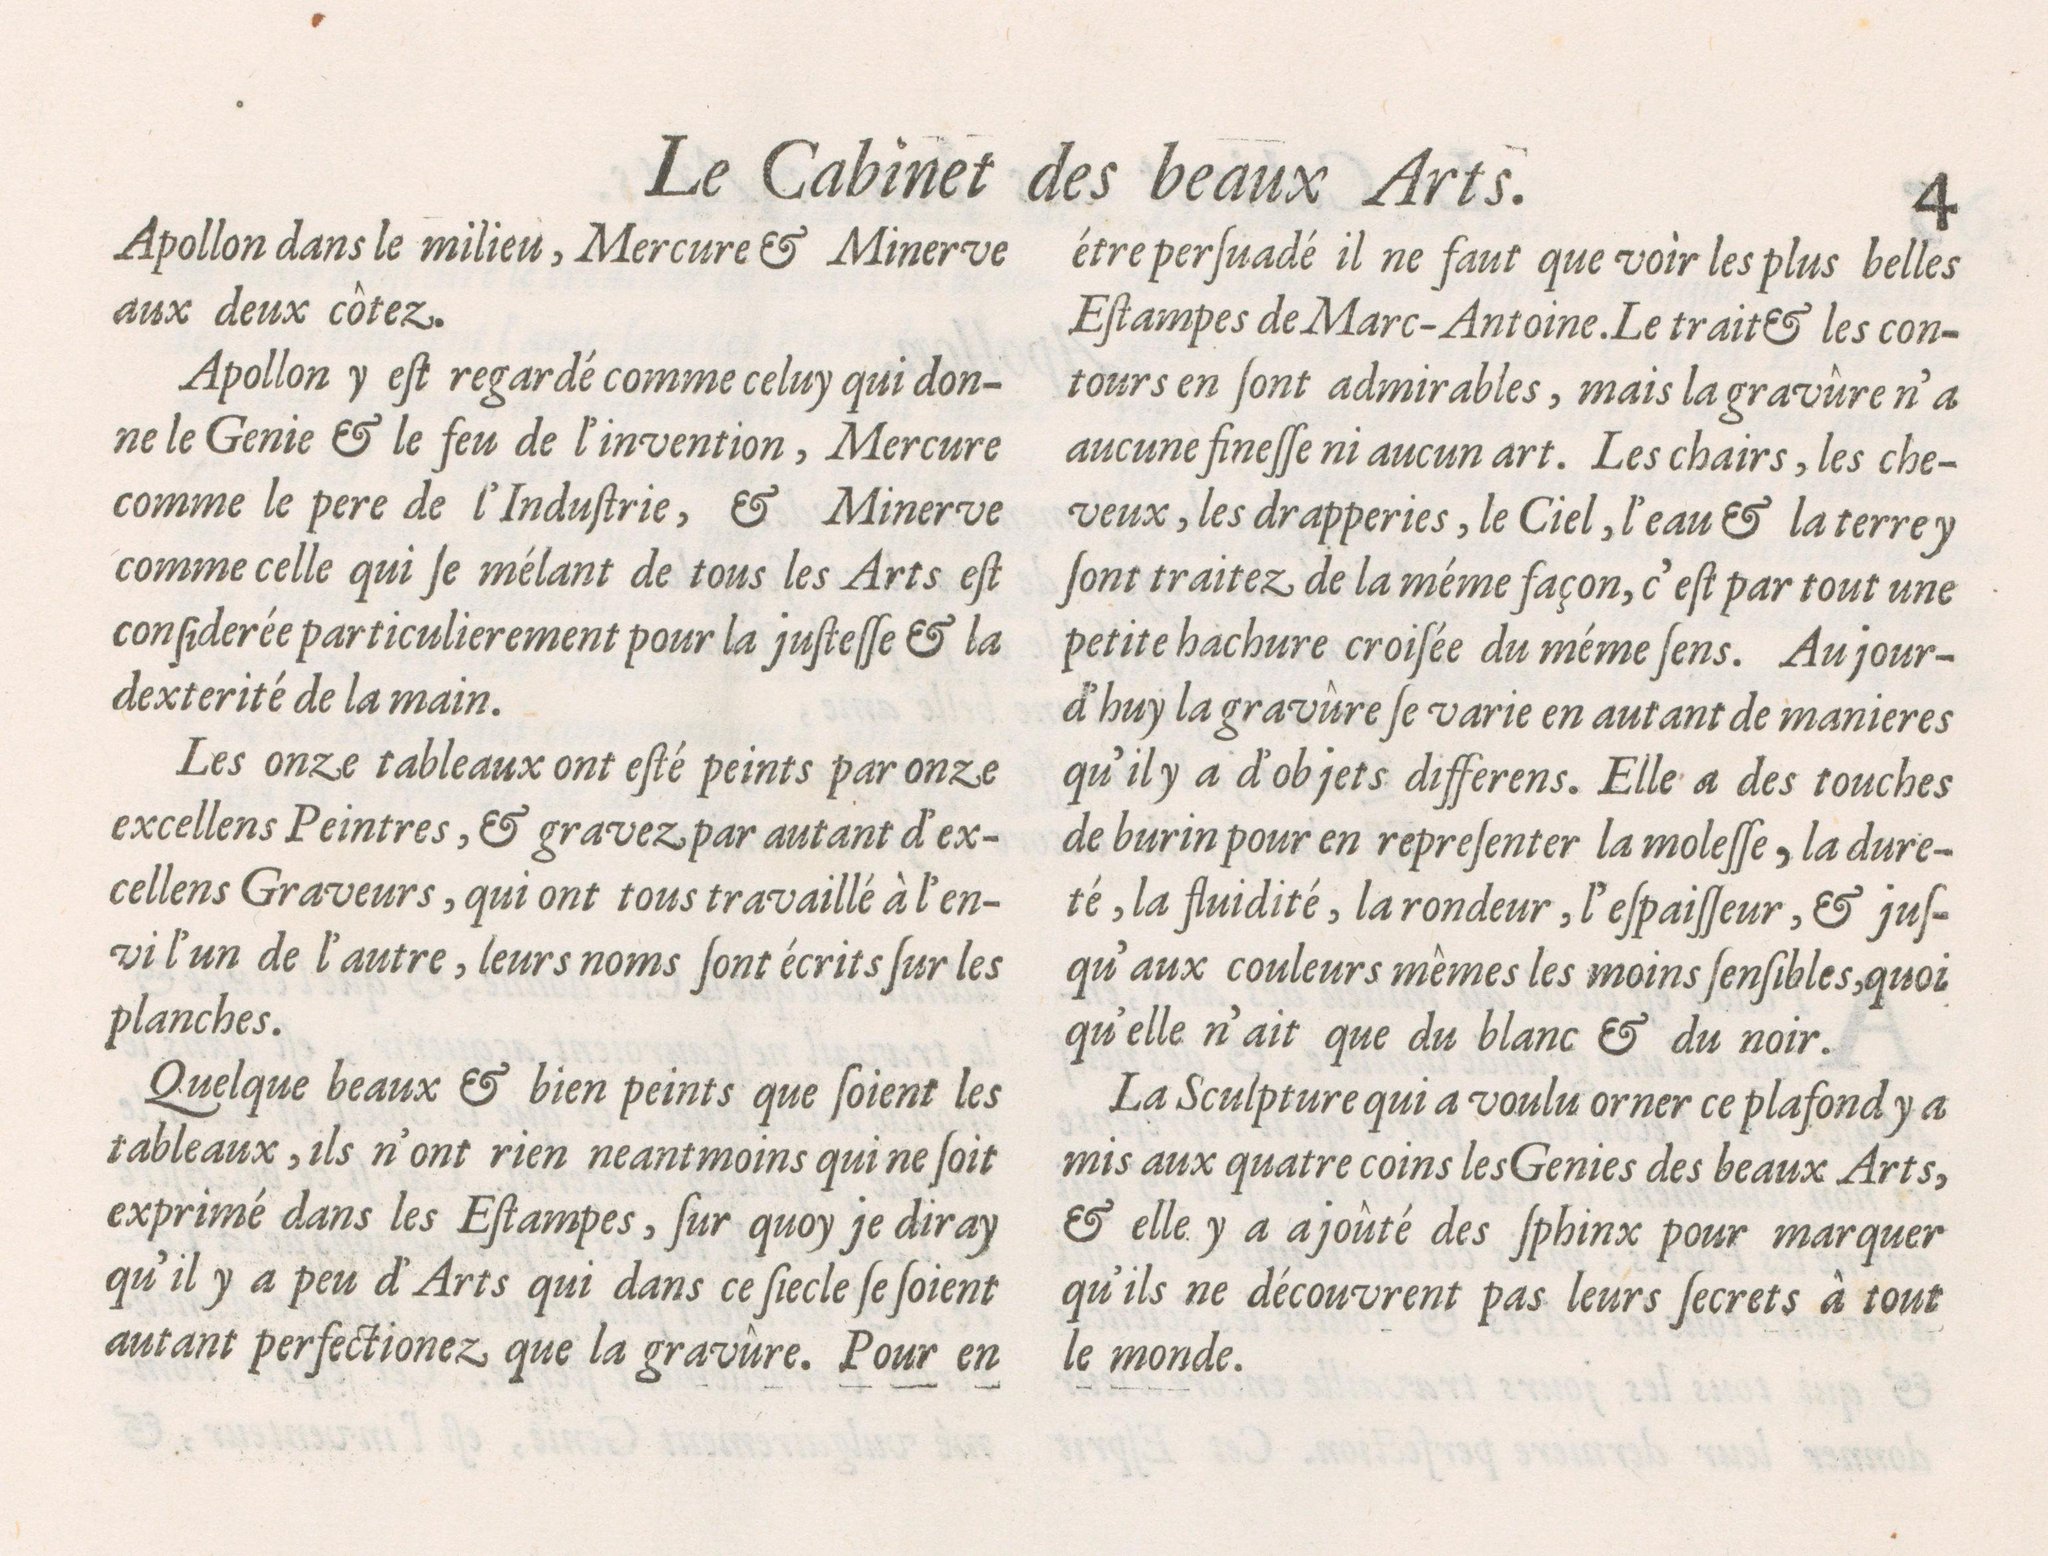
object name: text sheet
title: Tekstblad met verklaring van de prenten, p. 4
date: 1695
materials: paper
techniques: letterpress printing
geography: paris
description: Verklaring van de prenten in het Frans. Pagina 4. Tekstblad maakt deel uit van een album.